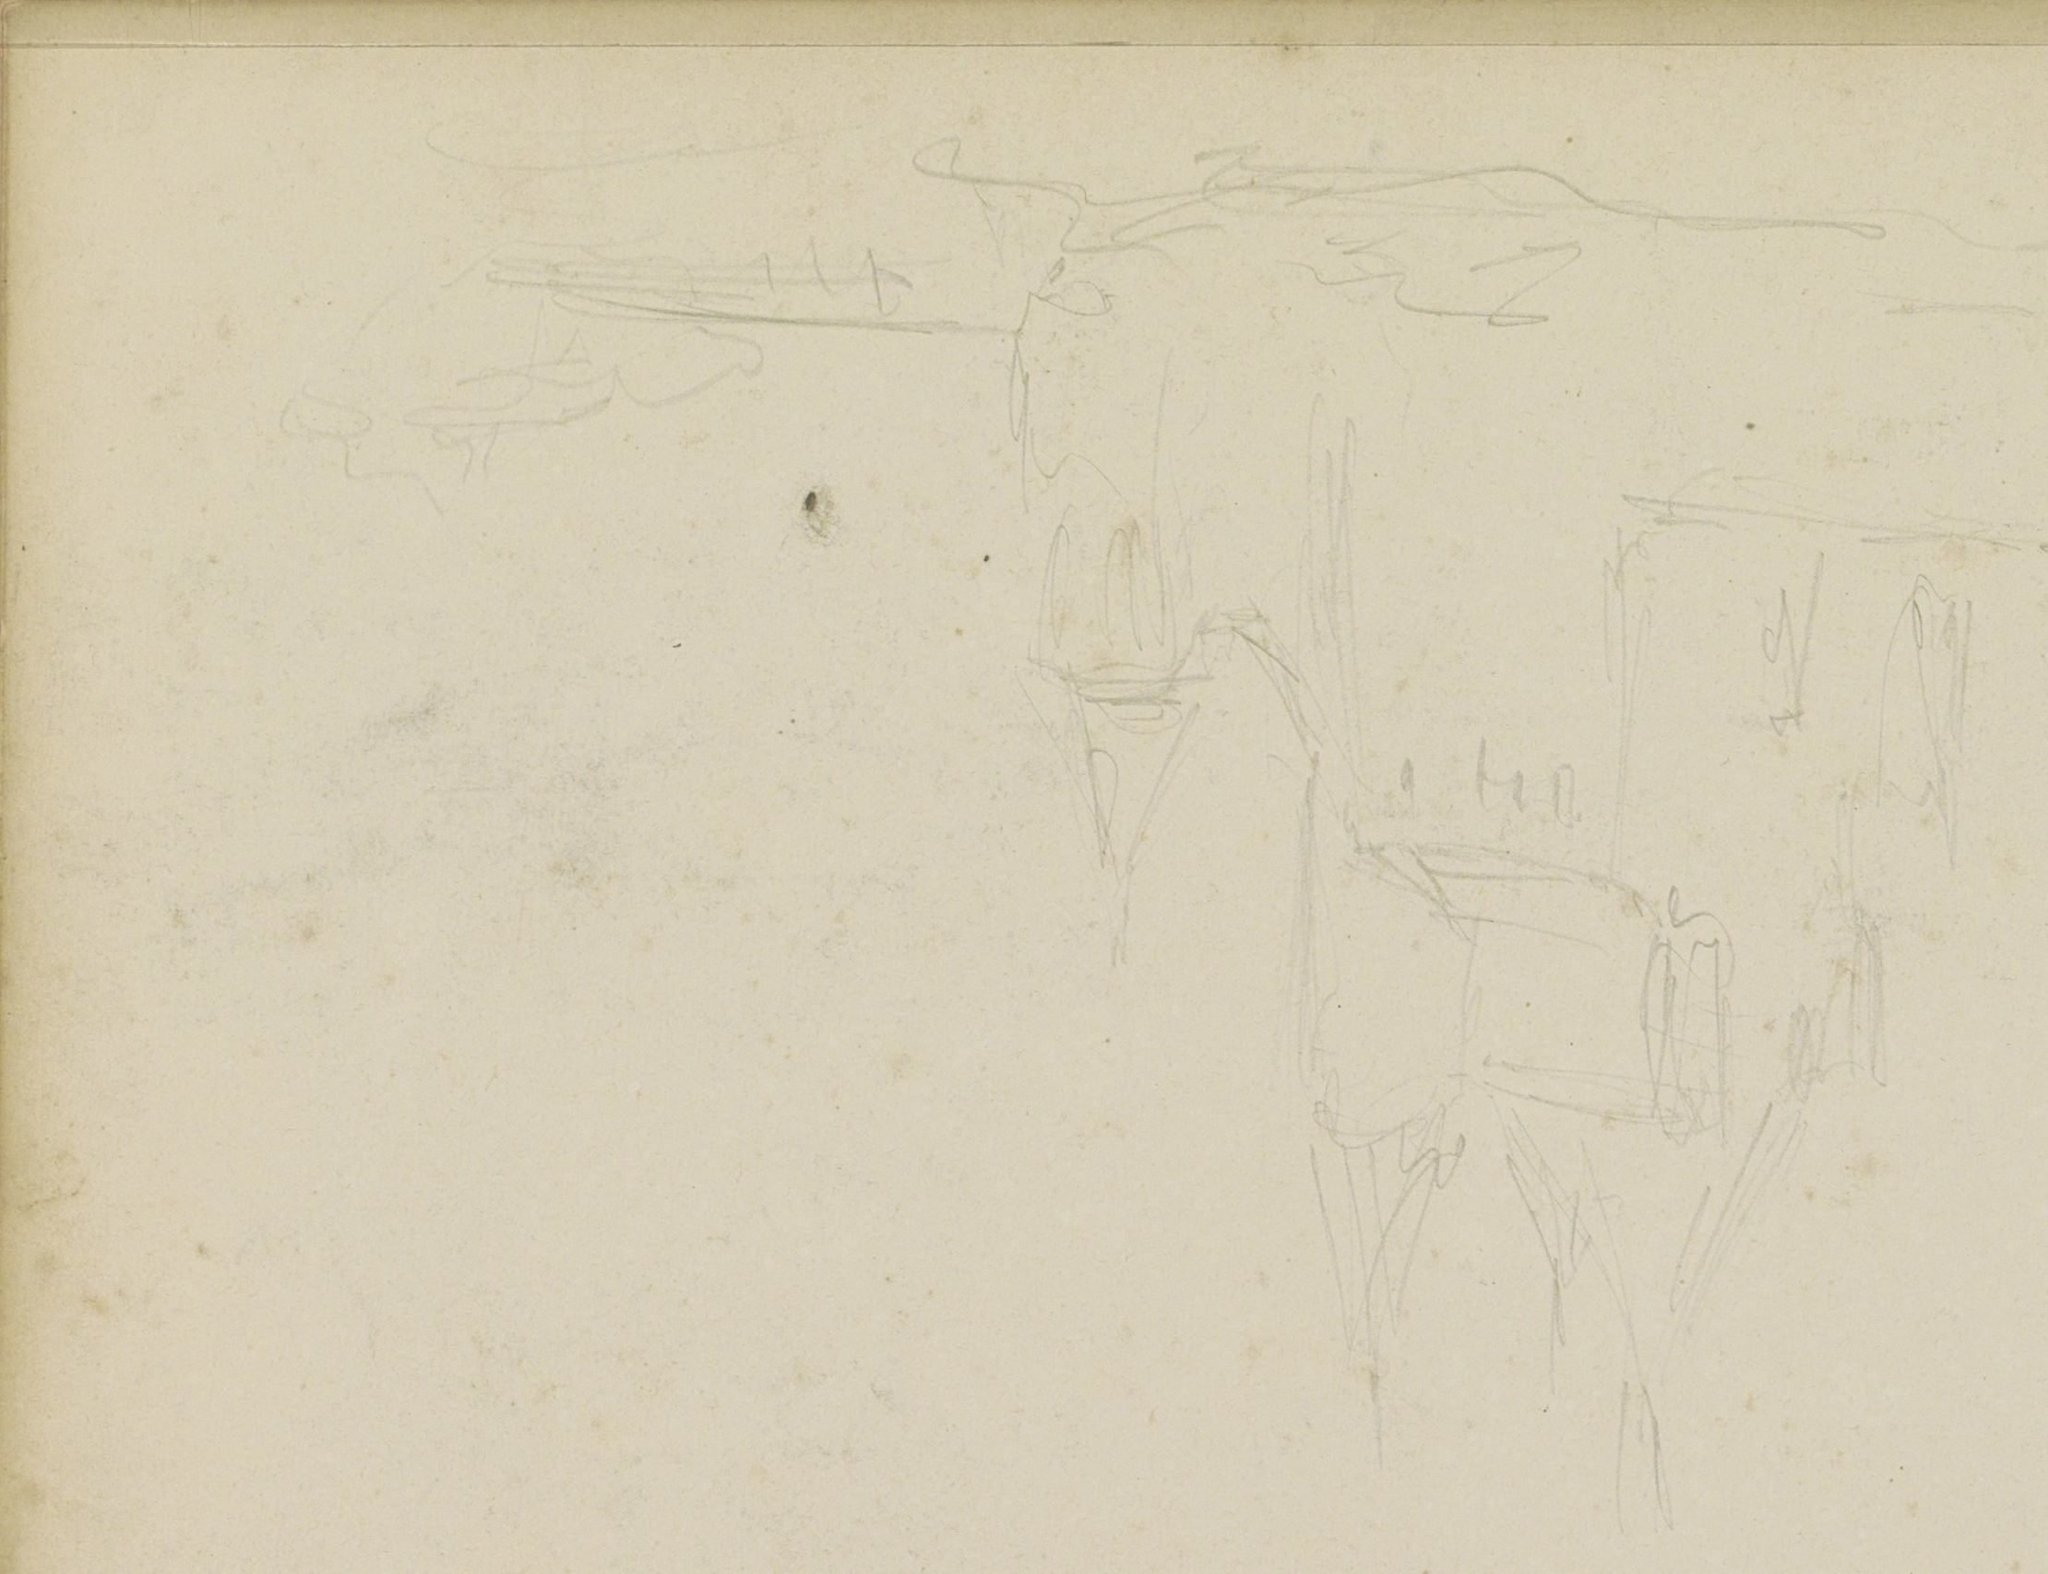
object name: sketchbook leaf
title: Gezicht op een gebouw met torens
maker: adrianus eversen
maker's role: draughtsman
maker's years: 1818-1897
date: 1828-1897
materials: paper, pencil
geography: netherlands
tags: tower (of house or building)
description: Gezicht op een gebouw met torens. Blad 20 verso uit een schetsboek met 41 bladen.